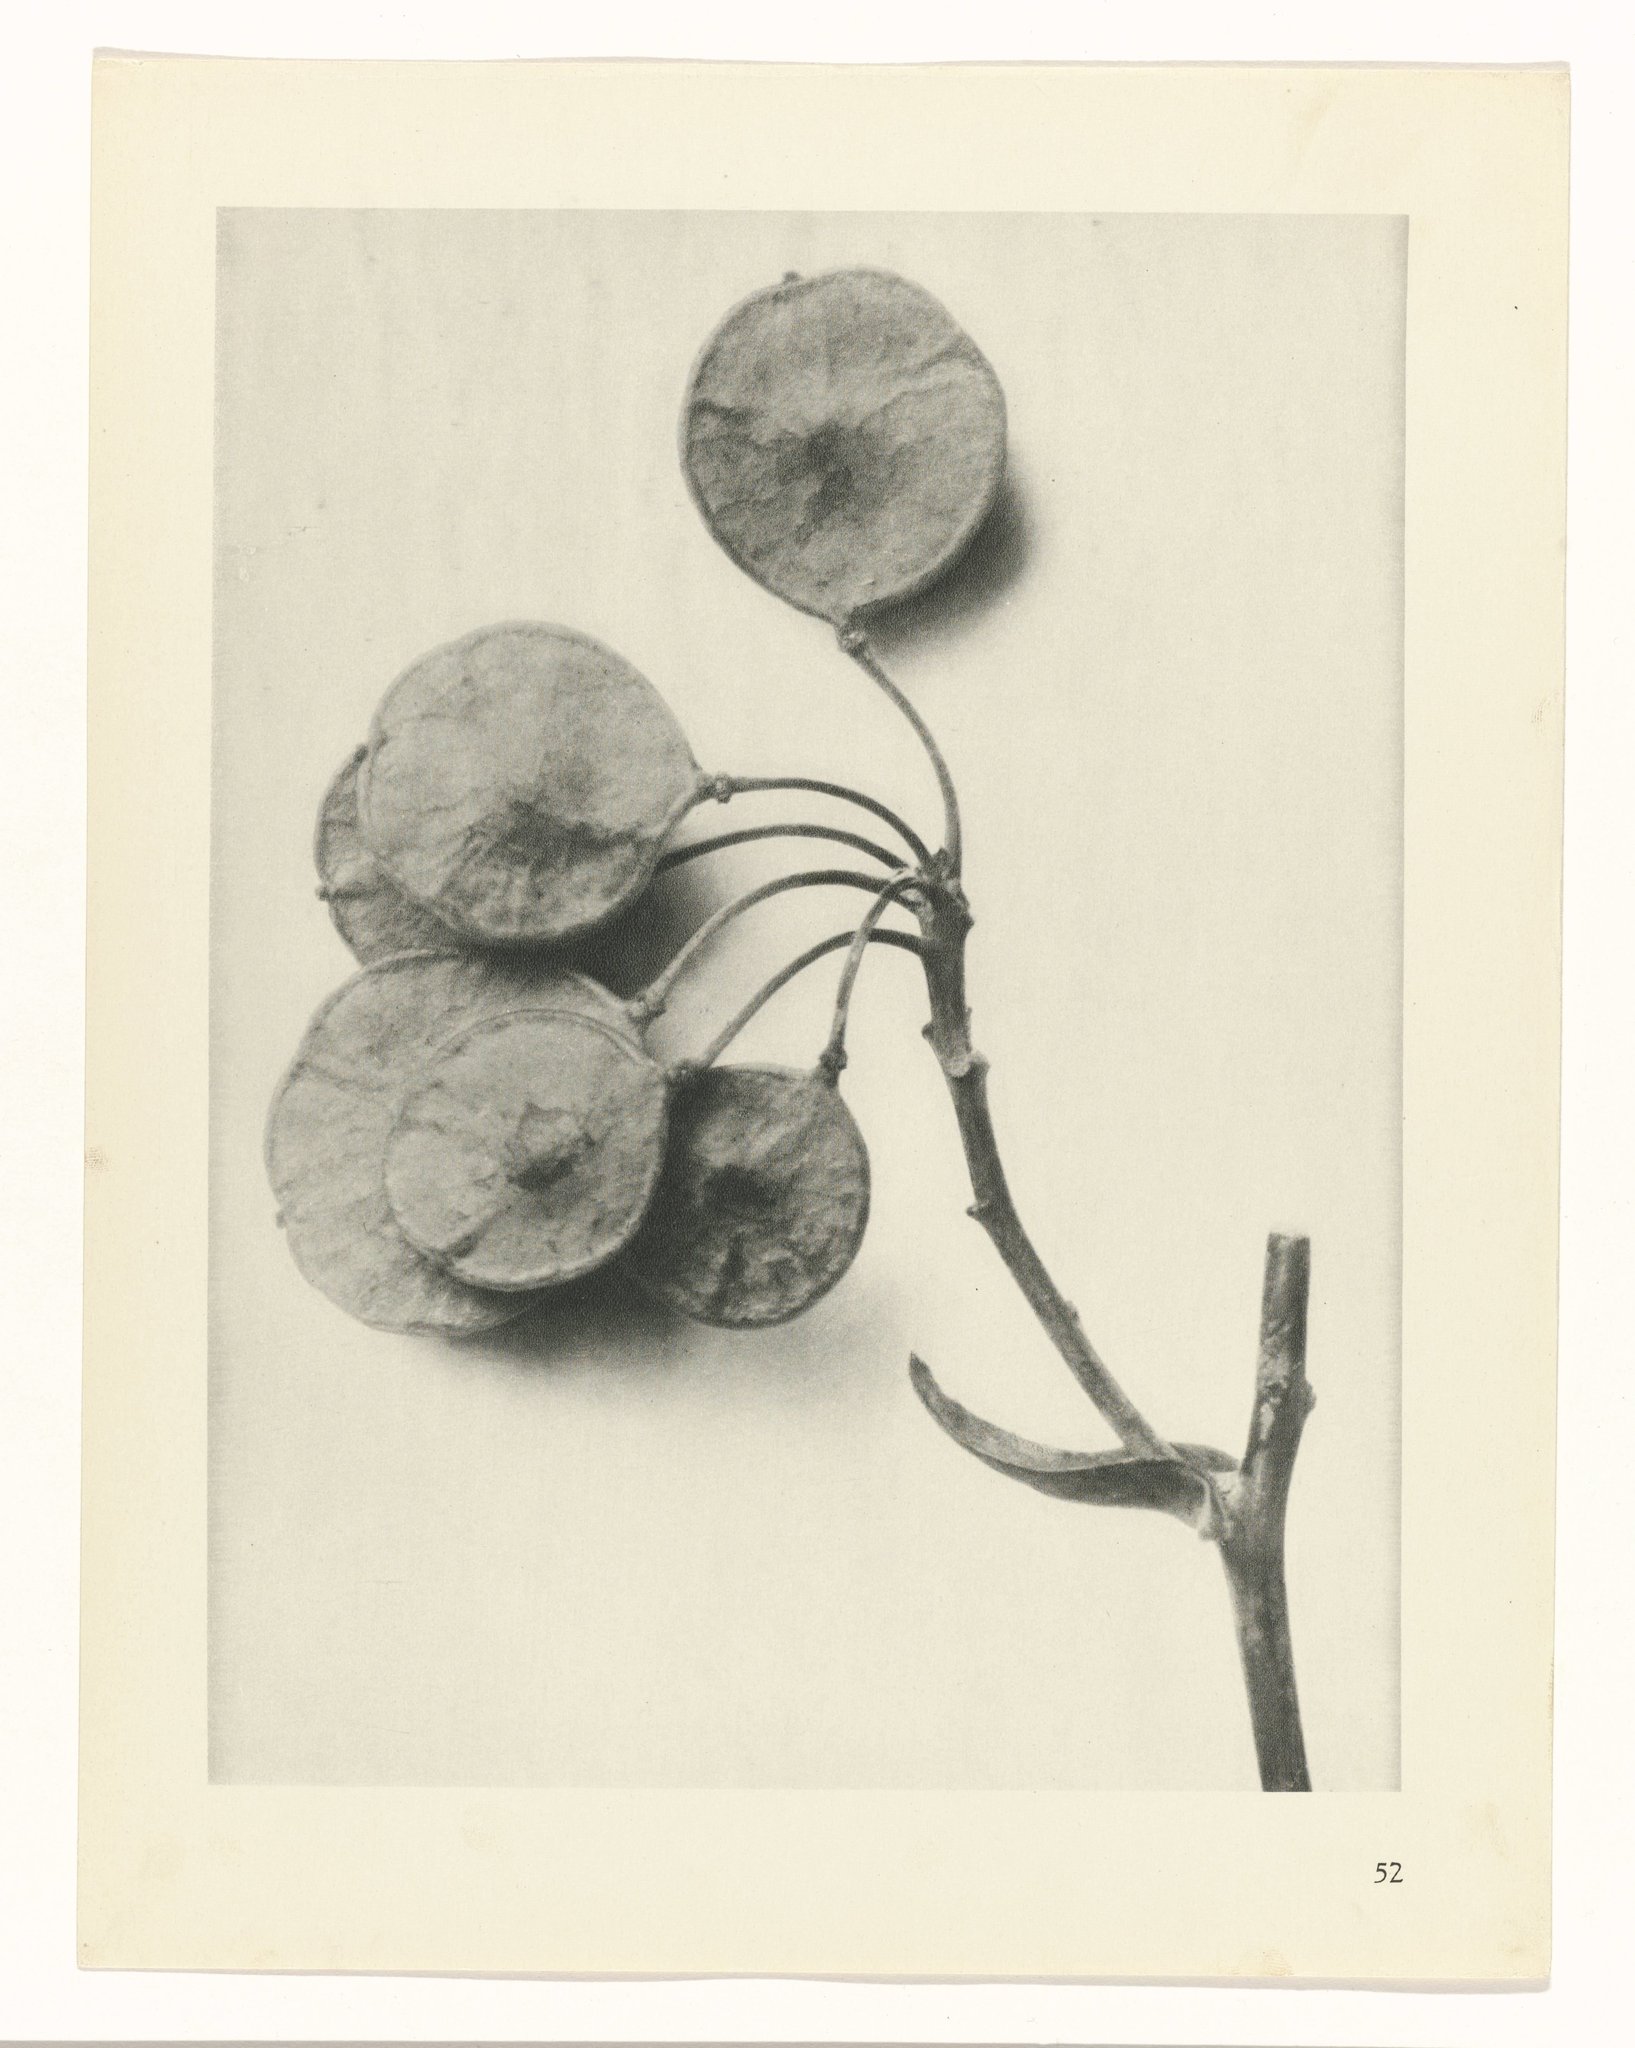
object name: photograph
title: Urformen der Kunst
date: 1928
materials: ink, paper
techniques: rotogravure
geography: berlin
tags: plants (in general)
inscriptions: number: ‘52’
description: facher Vergrößerung. Afkomstig uit losbladige uitgave.